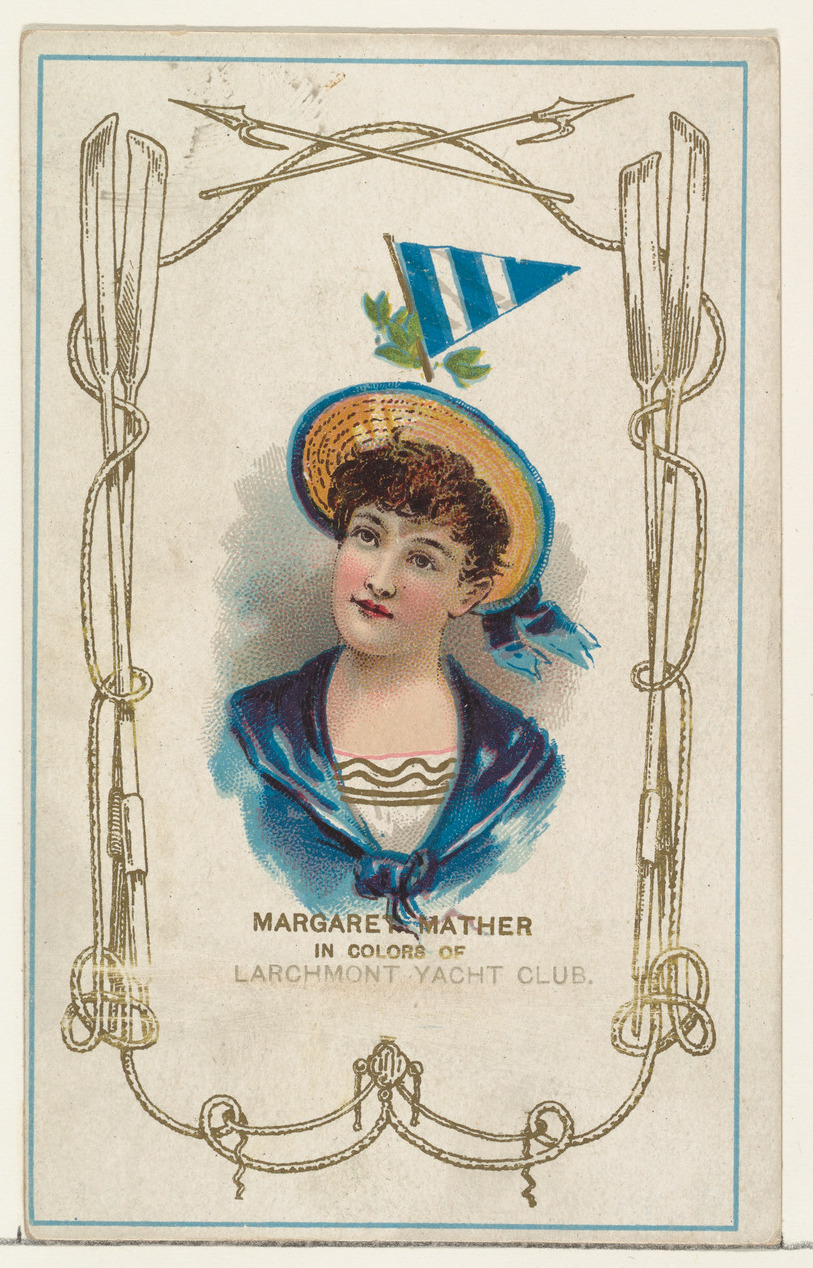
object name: print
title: Margaret Mather in Colors of the Larchmont Yach Club, from the Yacht Colors of the World series (N140) issued by Duke Sons & Co. to promote Honest Long Cut Tobacco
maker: w. duke, sons & co.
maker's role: publisher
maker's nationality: american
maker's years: 1870-1920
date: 1890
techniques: color lithograph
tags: portraits,women,flags